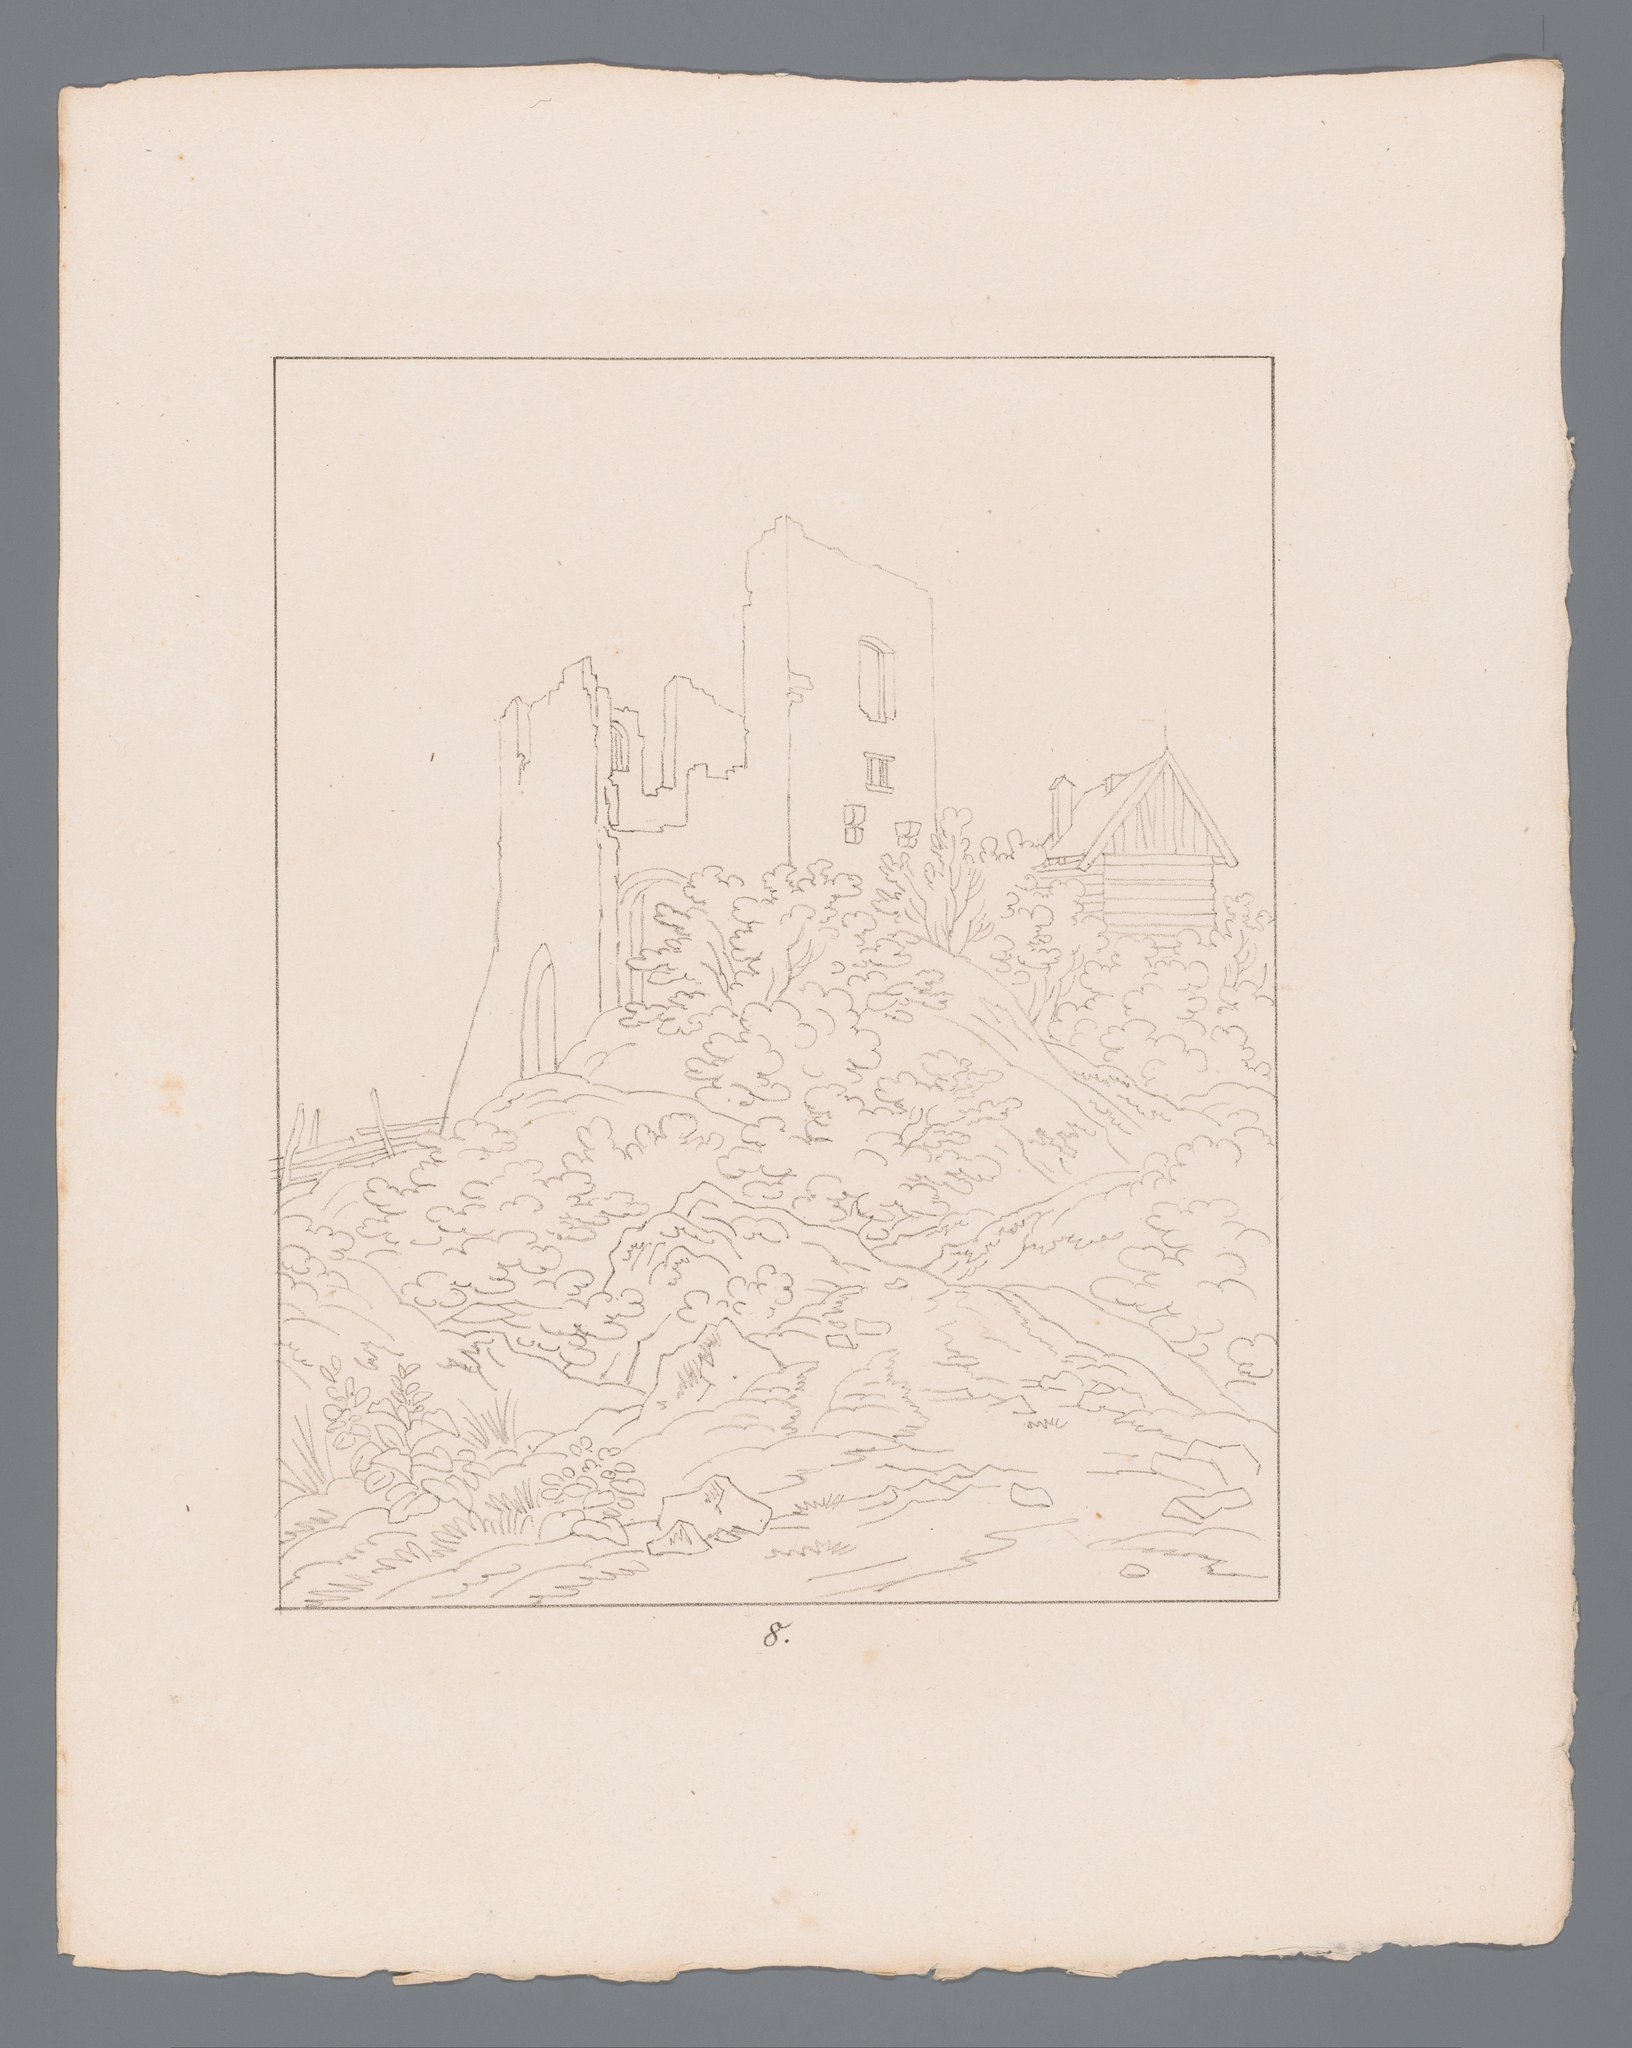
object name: print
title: Vorlagen für Landschaft-Zeichner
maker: max josef wagenbauer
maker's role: print maker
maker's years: 1774-1829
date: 1823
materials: paper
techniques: lithograph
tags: landscape with ruins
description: Onderdeel van een tweedelige serie waarvan het tweede deel bestaat uit een titelprent en twaalf voorstellingen van takken, bladeren, bomen en landschappen. De verder uitgewerkte versie van dit gezicht op een ruïne is ook onderdeel van deze serie: BI-2012-2901-2-9.